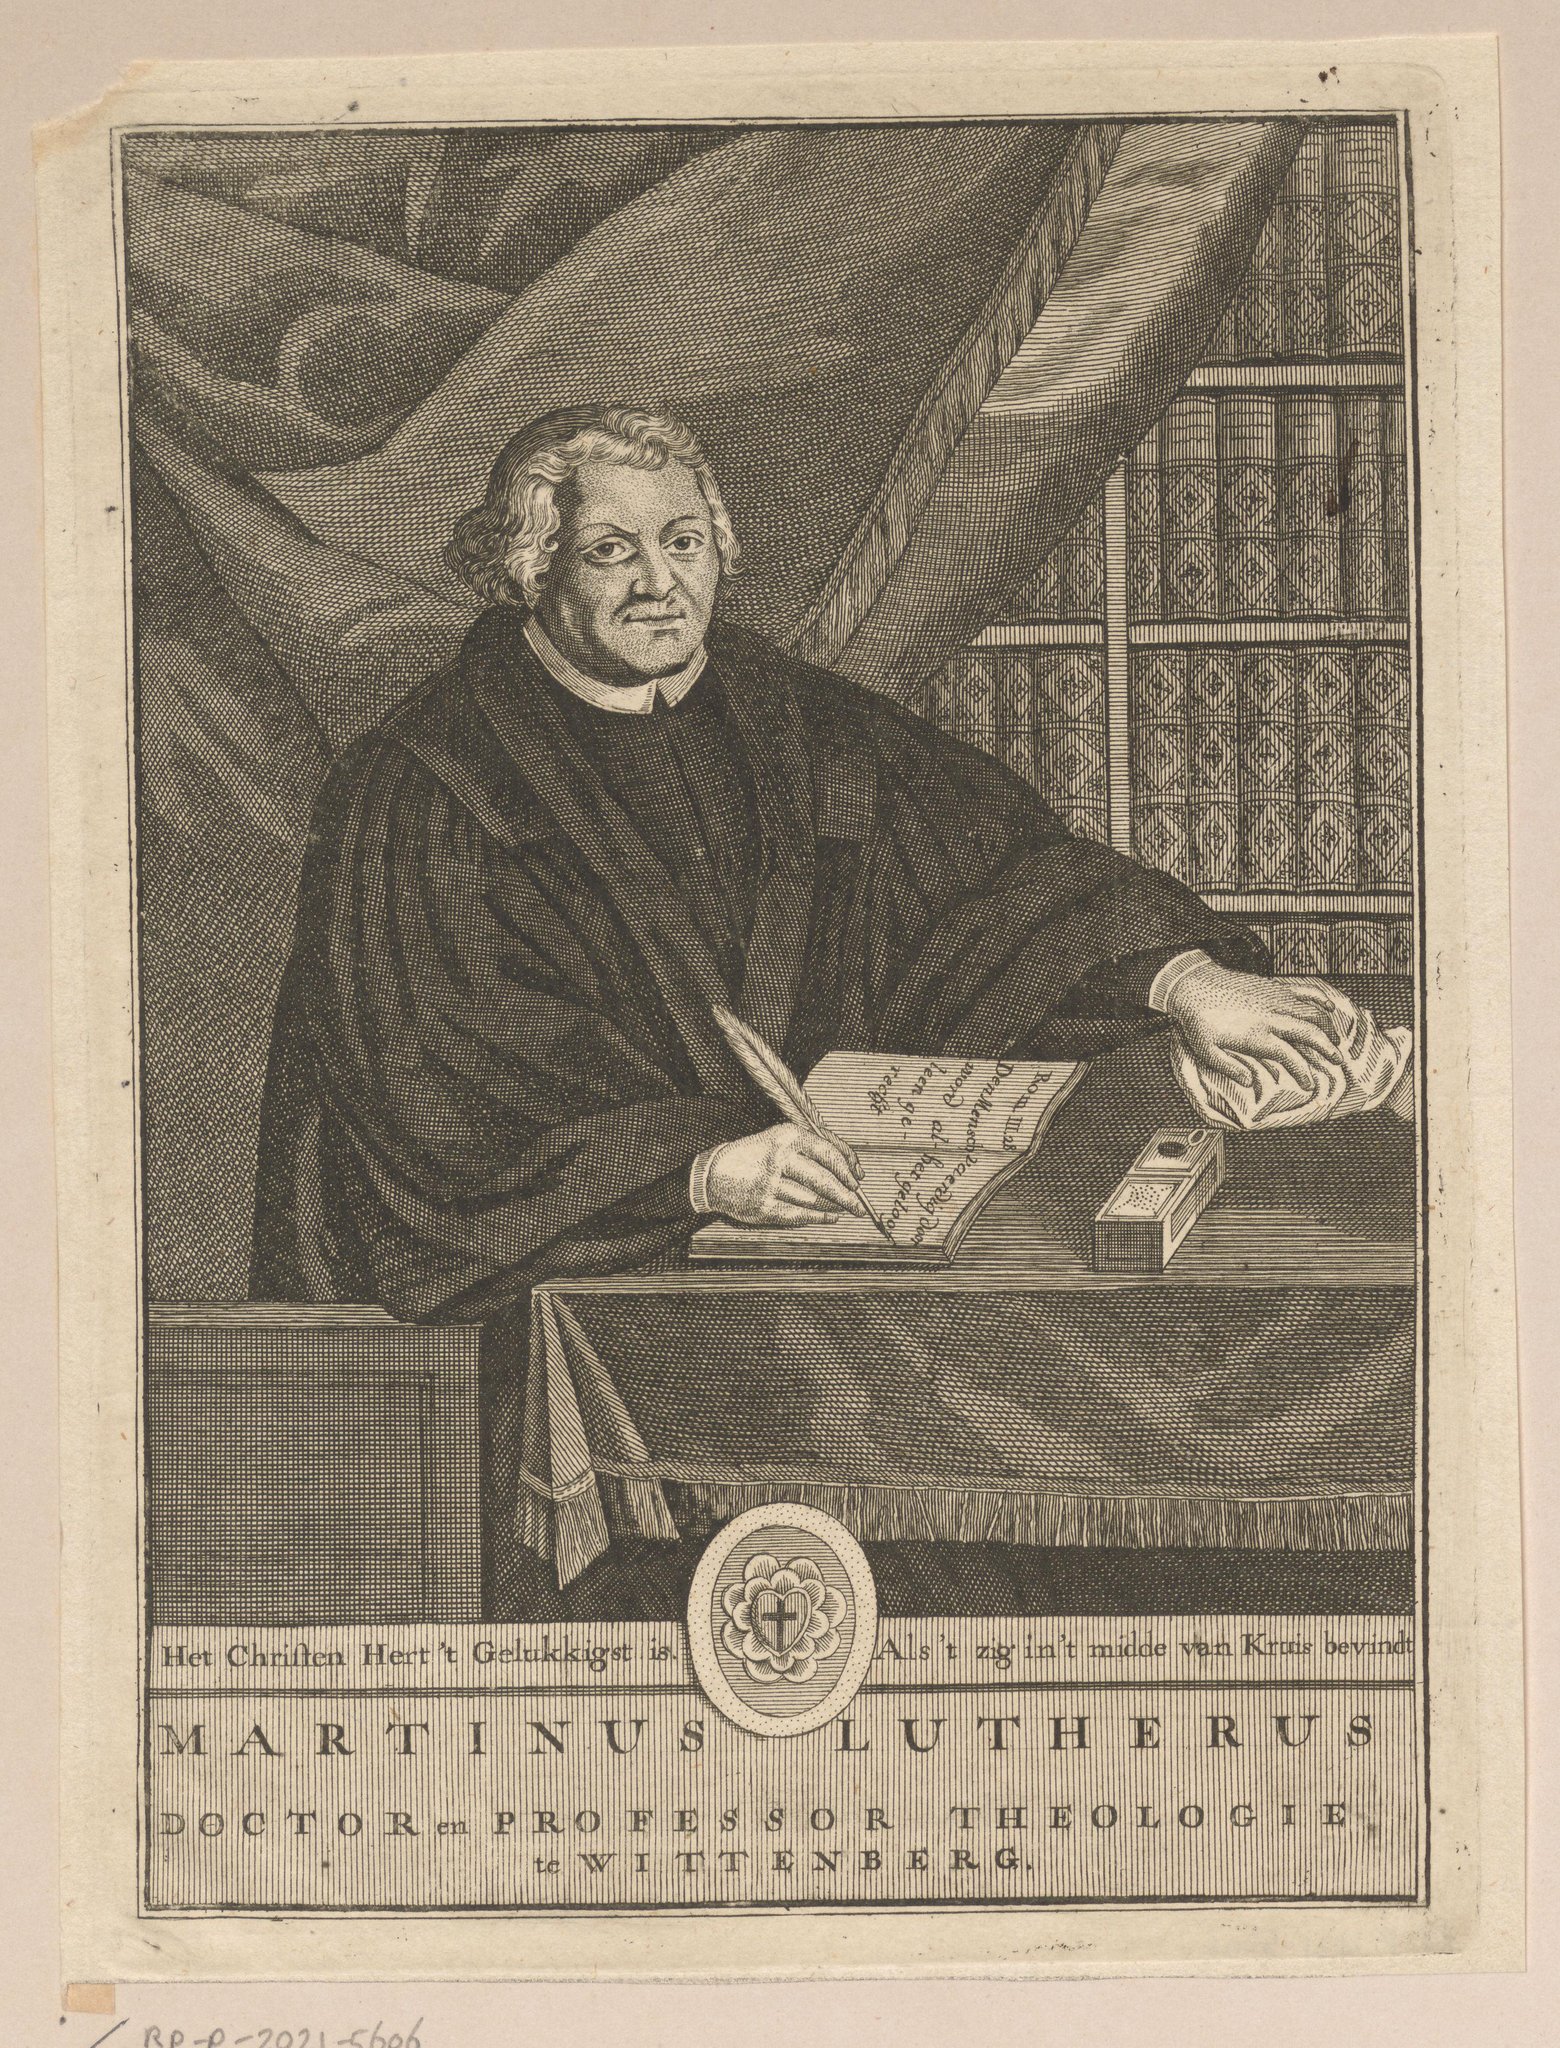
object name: print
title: Portret van Martin Luther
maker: Anonymous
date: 1700-1799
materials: paper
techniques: etching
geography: northern netherlands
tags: priest, martin luther, handwriting, writing as activity, scholar in his study, theologian, historical persons, armorial bearing, heraldry